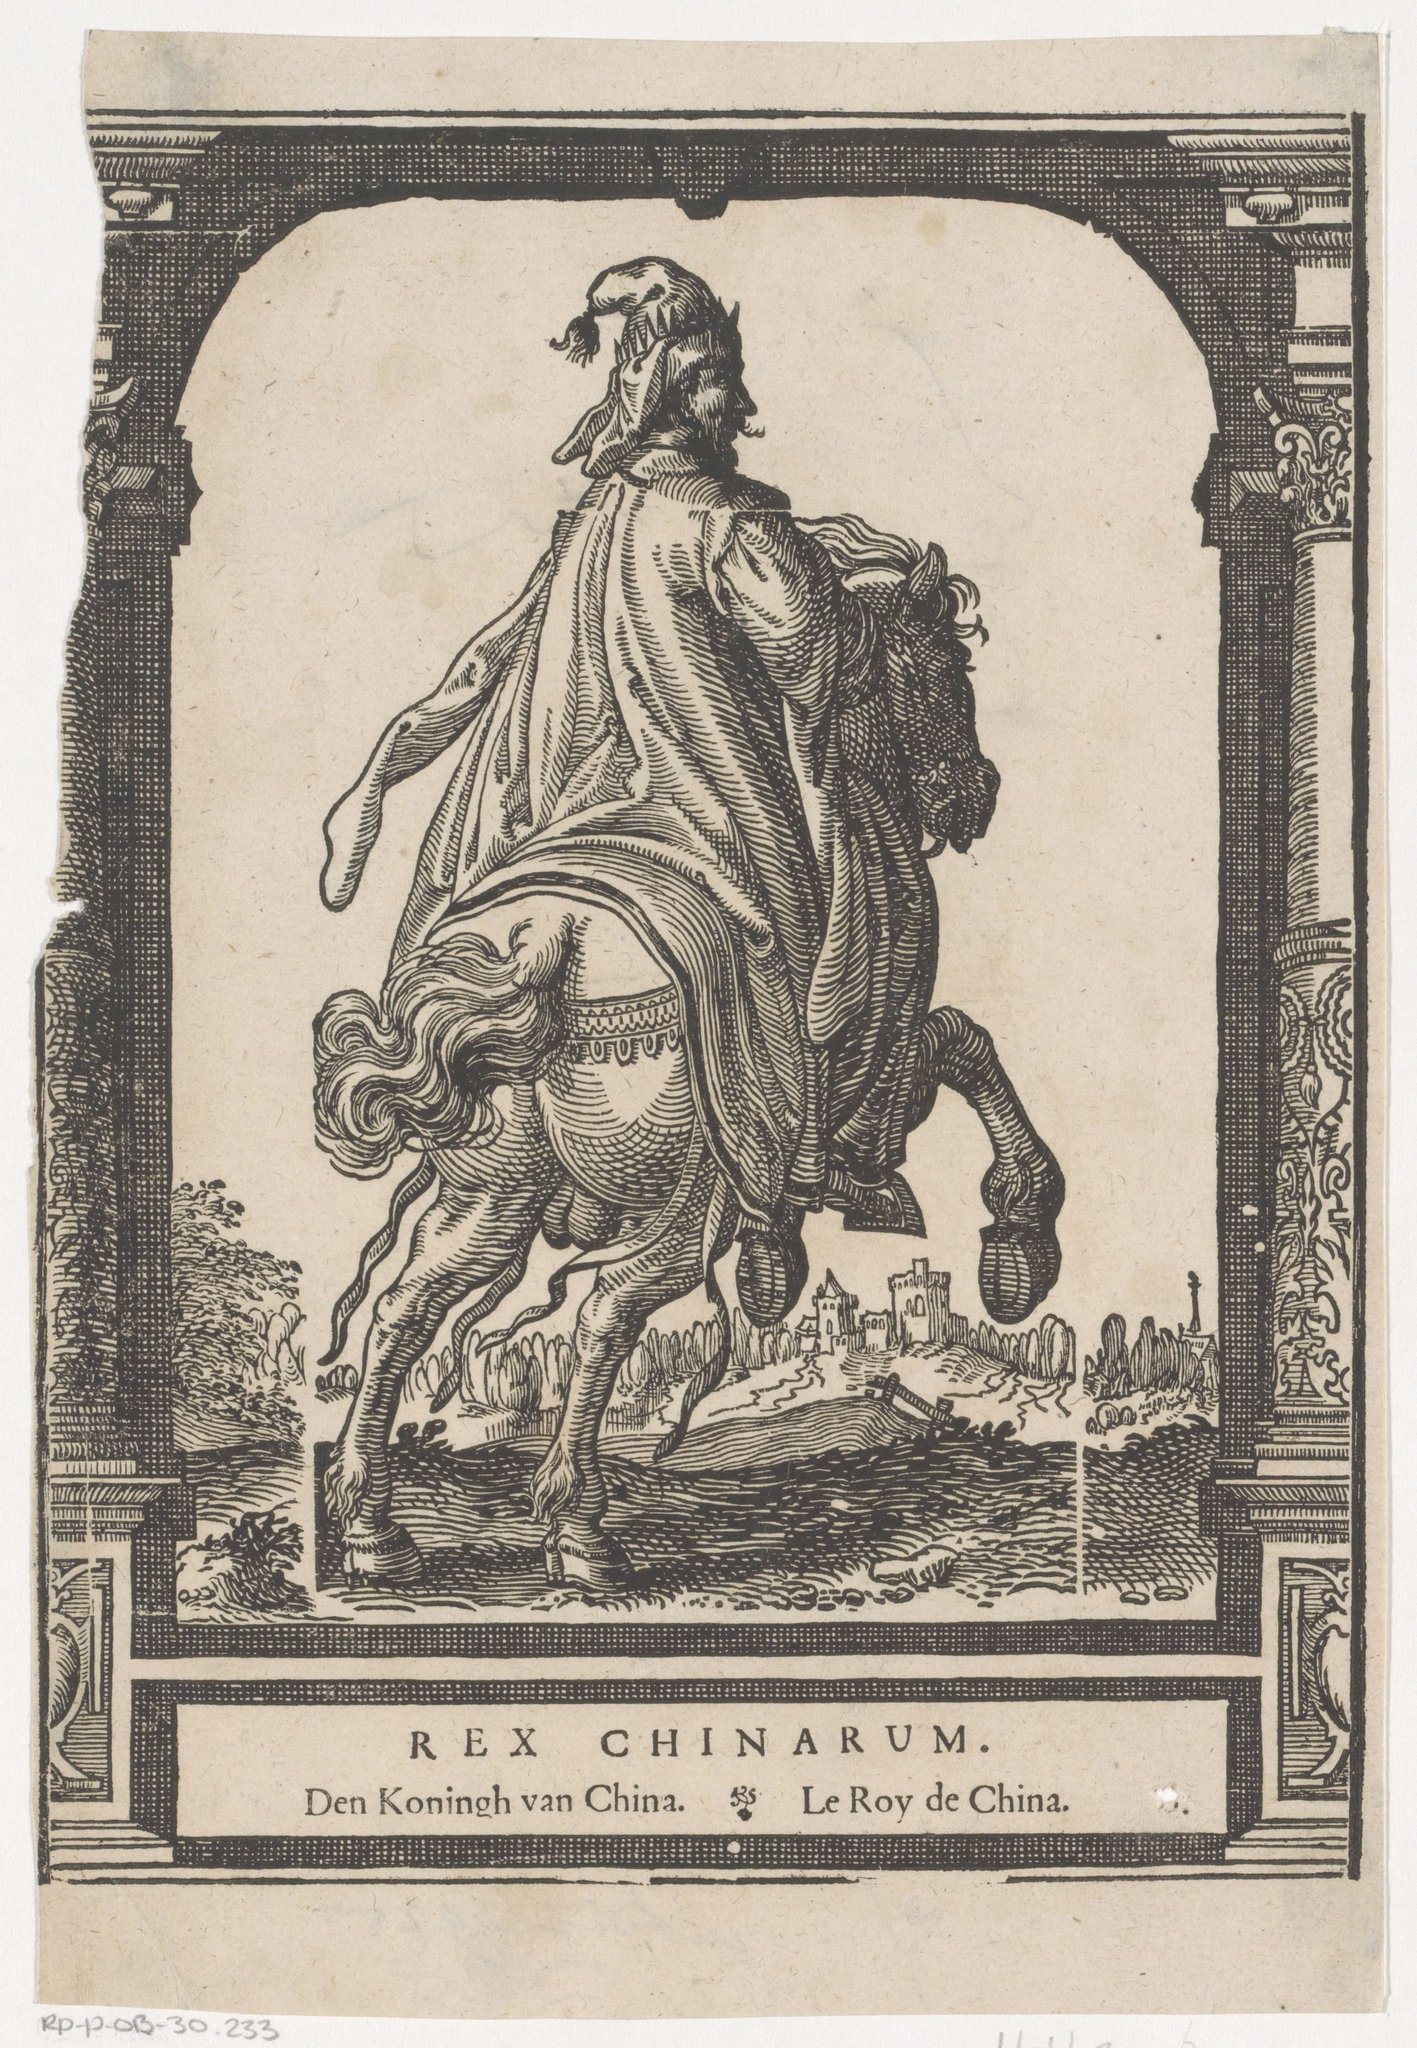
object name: print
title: Ruiterportret van een koning van China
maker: philips serwouters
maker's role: print maker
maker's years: 1591-1650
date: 1601-1650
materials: paper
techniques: letterpress printing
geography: netherlands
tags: equestrian state-portrait, king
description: Ruiterportret van een koning van China in een geornamenteerde omlijsting met zuilen en in een kader zijn titel.